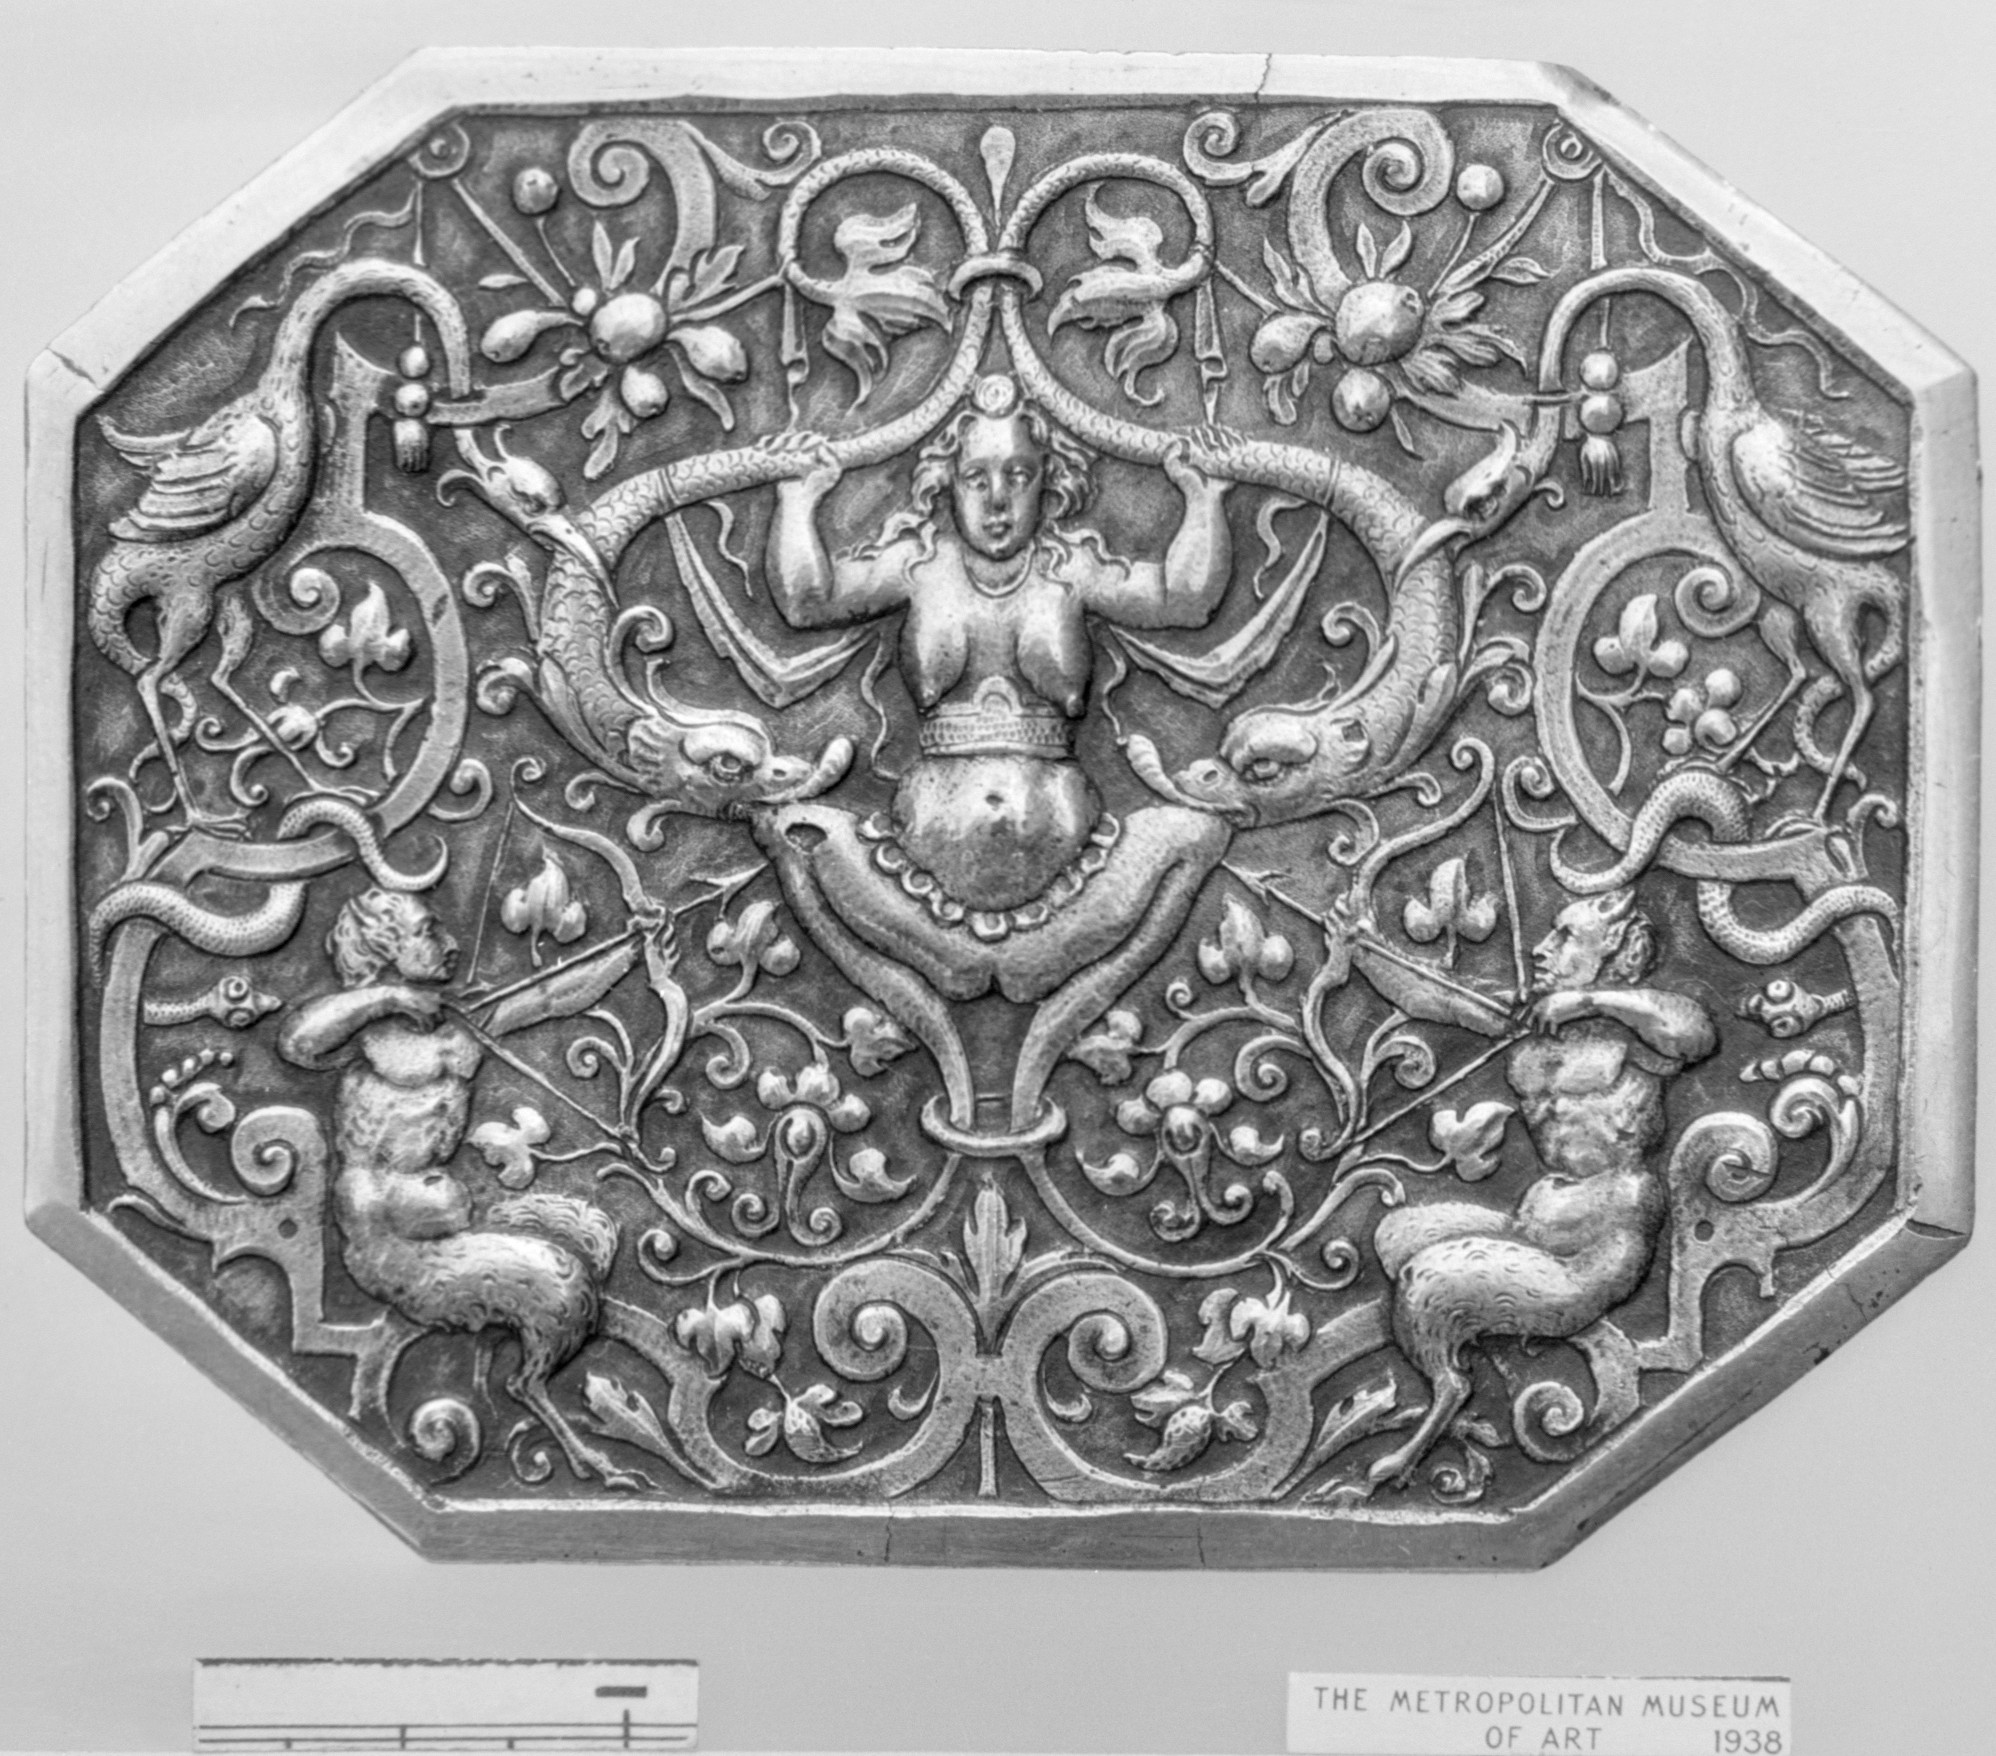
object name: plaquette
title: Plaquette, possibly a lid for a box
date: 1567-1600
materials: gilt bronze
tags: birds,bow and arrow,satyrs,dolphins